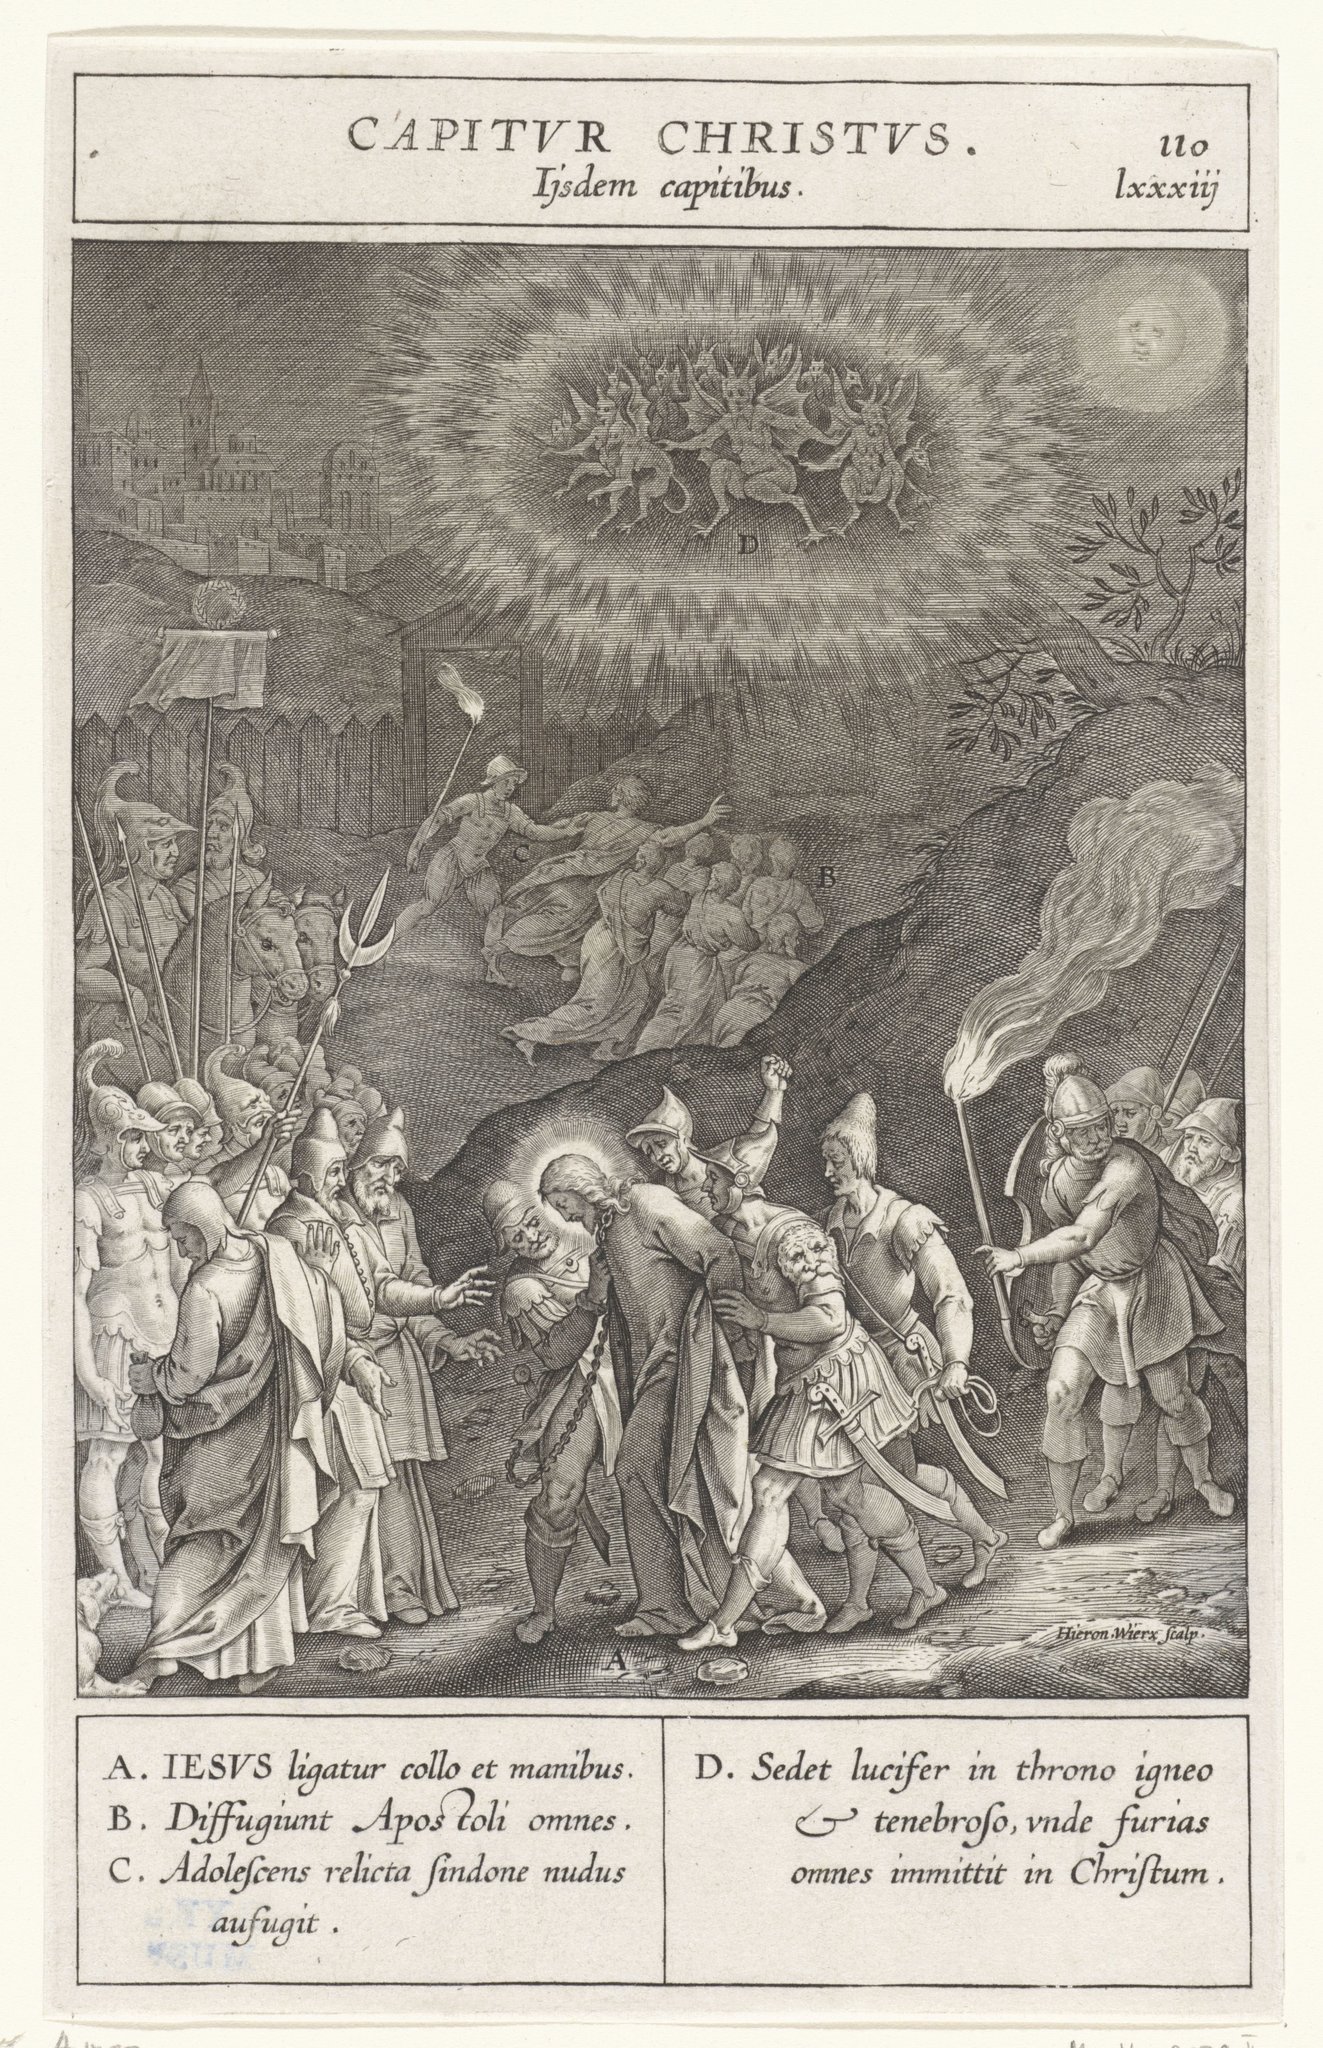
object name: print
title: Capitvr Christvs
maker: hieronymus wierix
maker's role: draughtsman, print maker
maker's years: 1553-1619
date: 1593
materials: paper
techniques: engraving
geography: antwerp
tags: the arrest of christ ~ garden of gethsemane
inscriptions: collector's mark: Lugt 2165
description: De soldaten omsingelen en arresteren Christus. Zijn handen zijn op de rug gebonden. Bij verschillende elementen uit de voorstelling staan letters die corresponderen met de legenda in de marge.